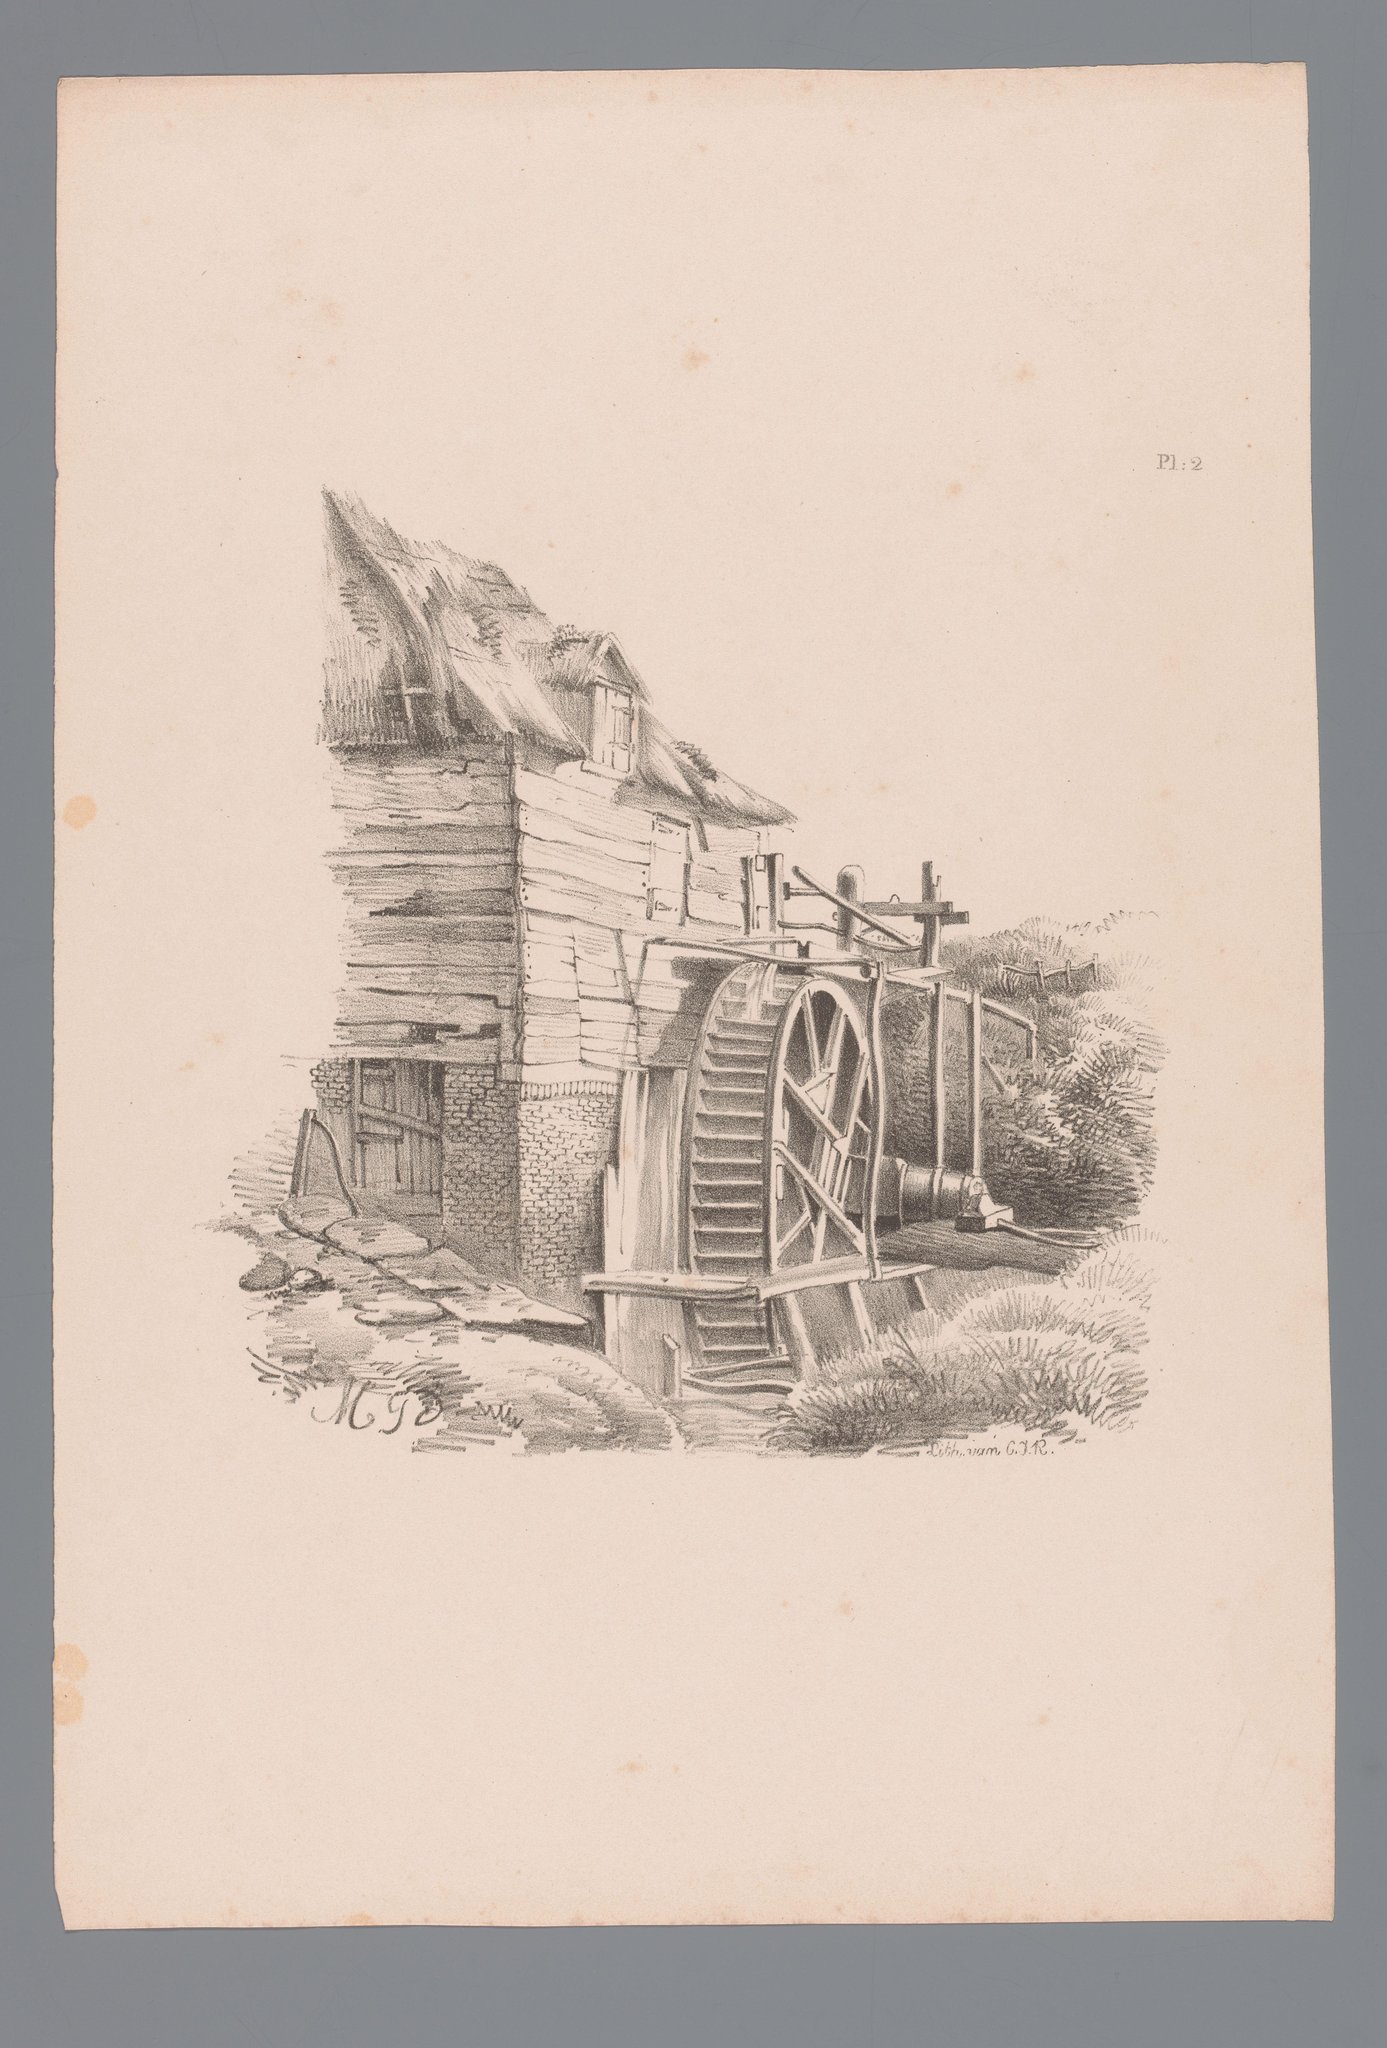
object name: print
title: Geldersche landschap Studien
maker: christiaan johannes reinhold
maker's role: steendrukker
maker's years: 1810-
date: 1838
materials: paper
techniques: lithograph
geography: amsterdam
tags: paddle wheel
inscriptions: collector's mark: Lugt 2228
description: Een waterrad bij een molen. Onderdeel van een omslag met een serie van vier Gelderse landschappen.